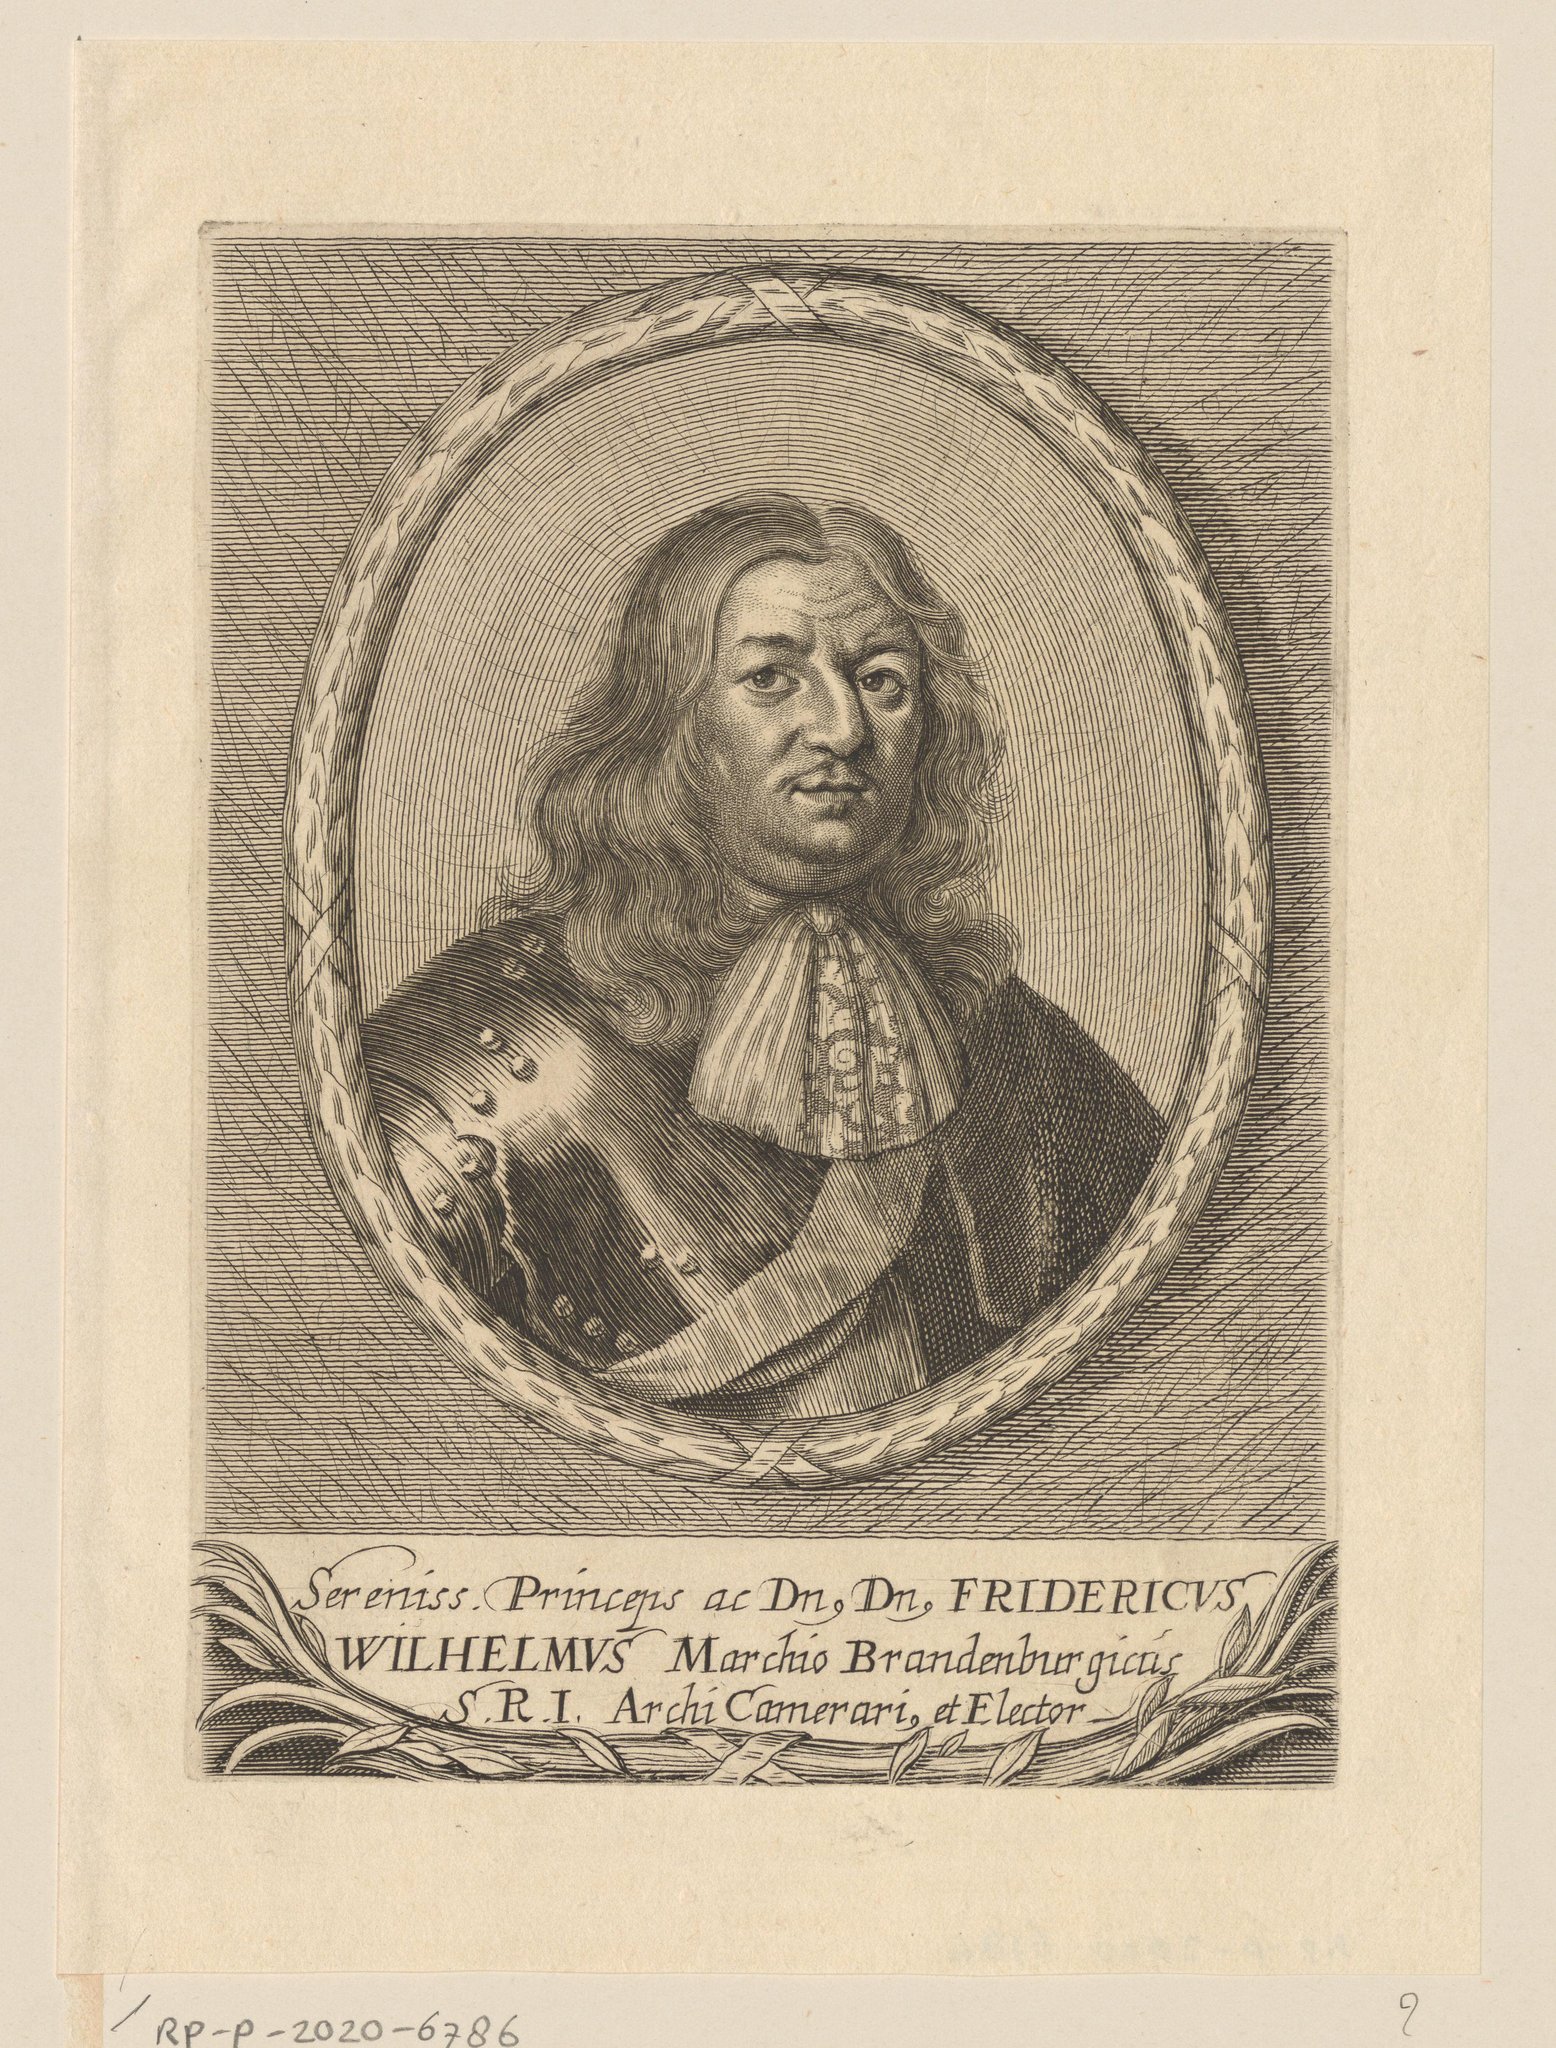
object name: print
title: Portret van Frederik Willem I van Brandenburg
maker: Anonymous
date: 1660-1700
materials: paper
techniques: engraving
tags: berlin, frederik willem van brandenburg (i), armour, historical persons